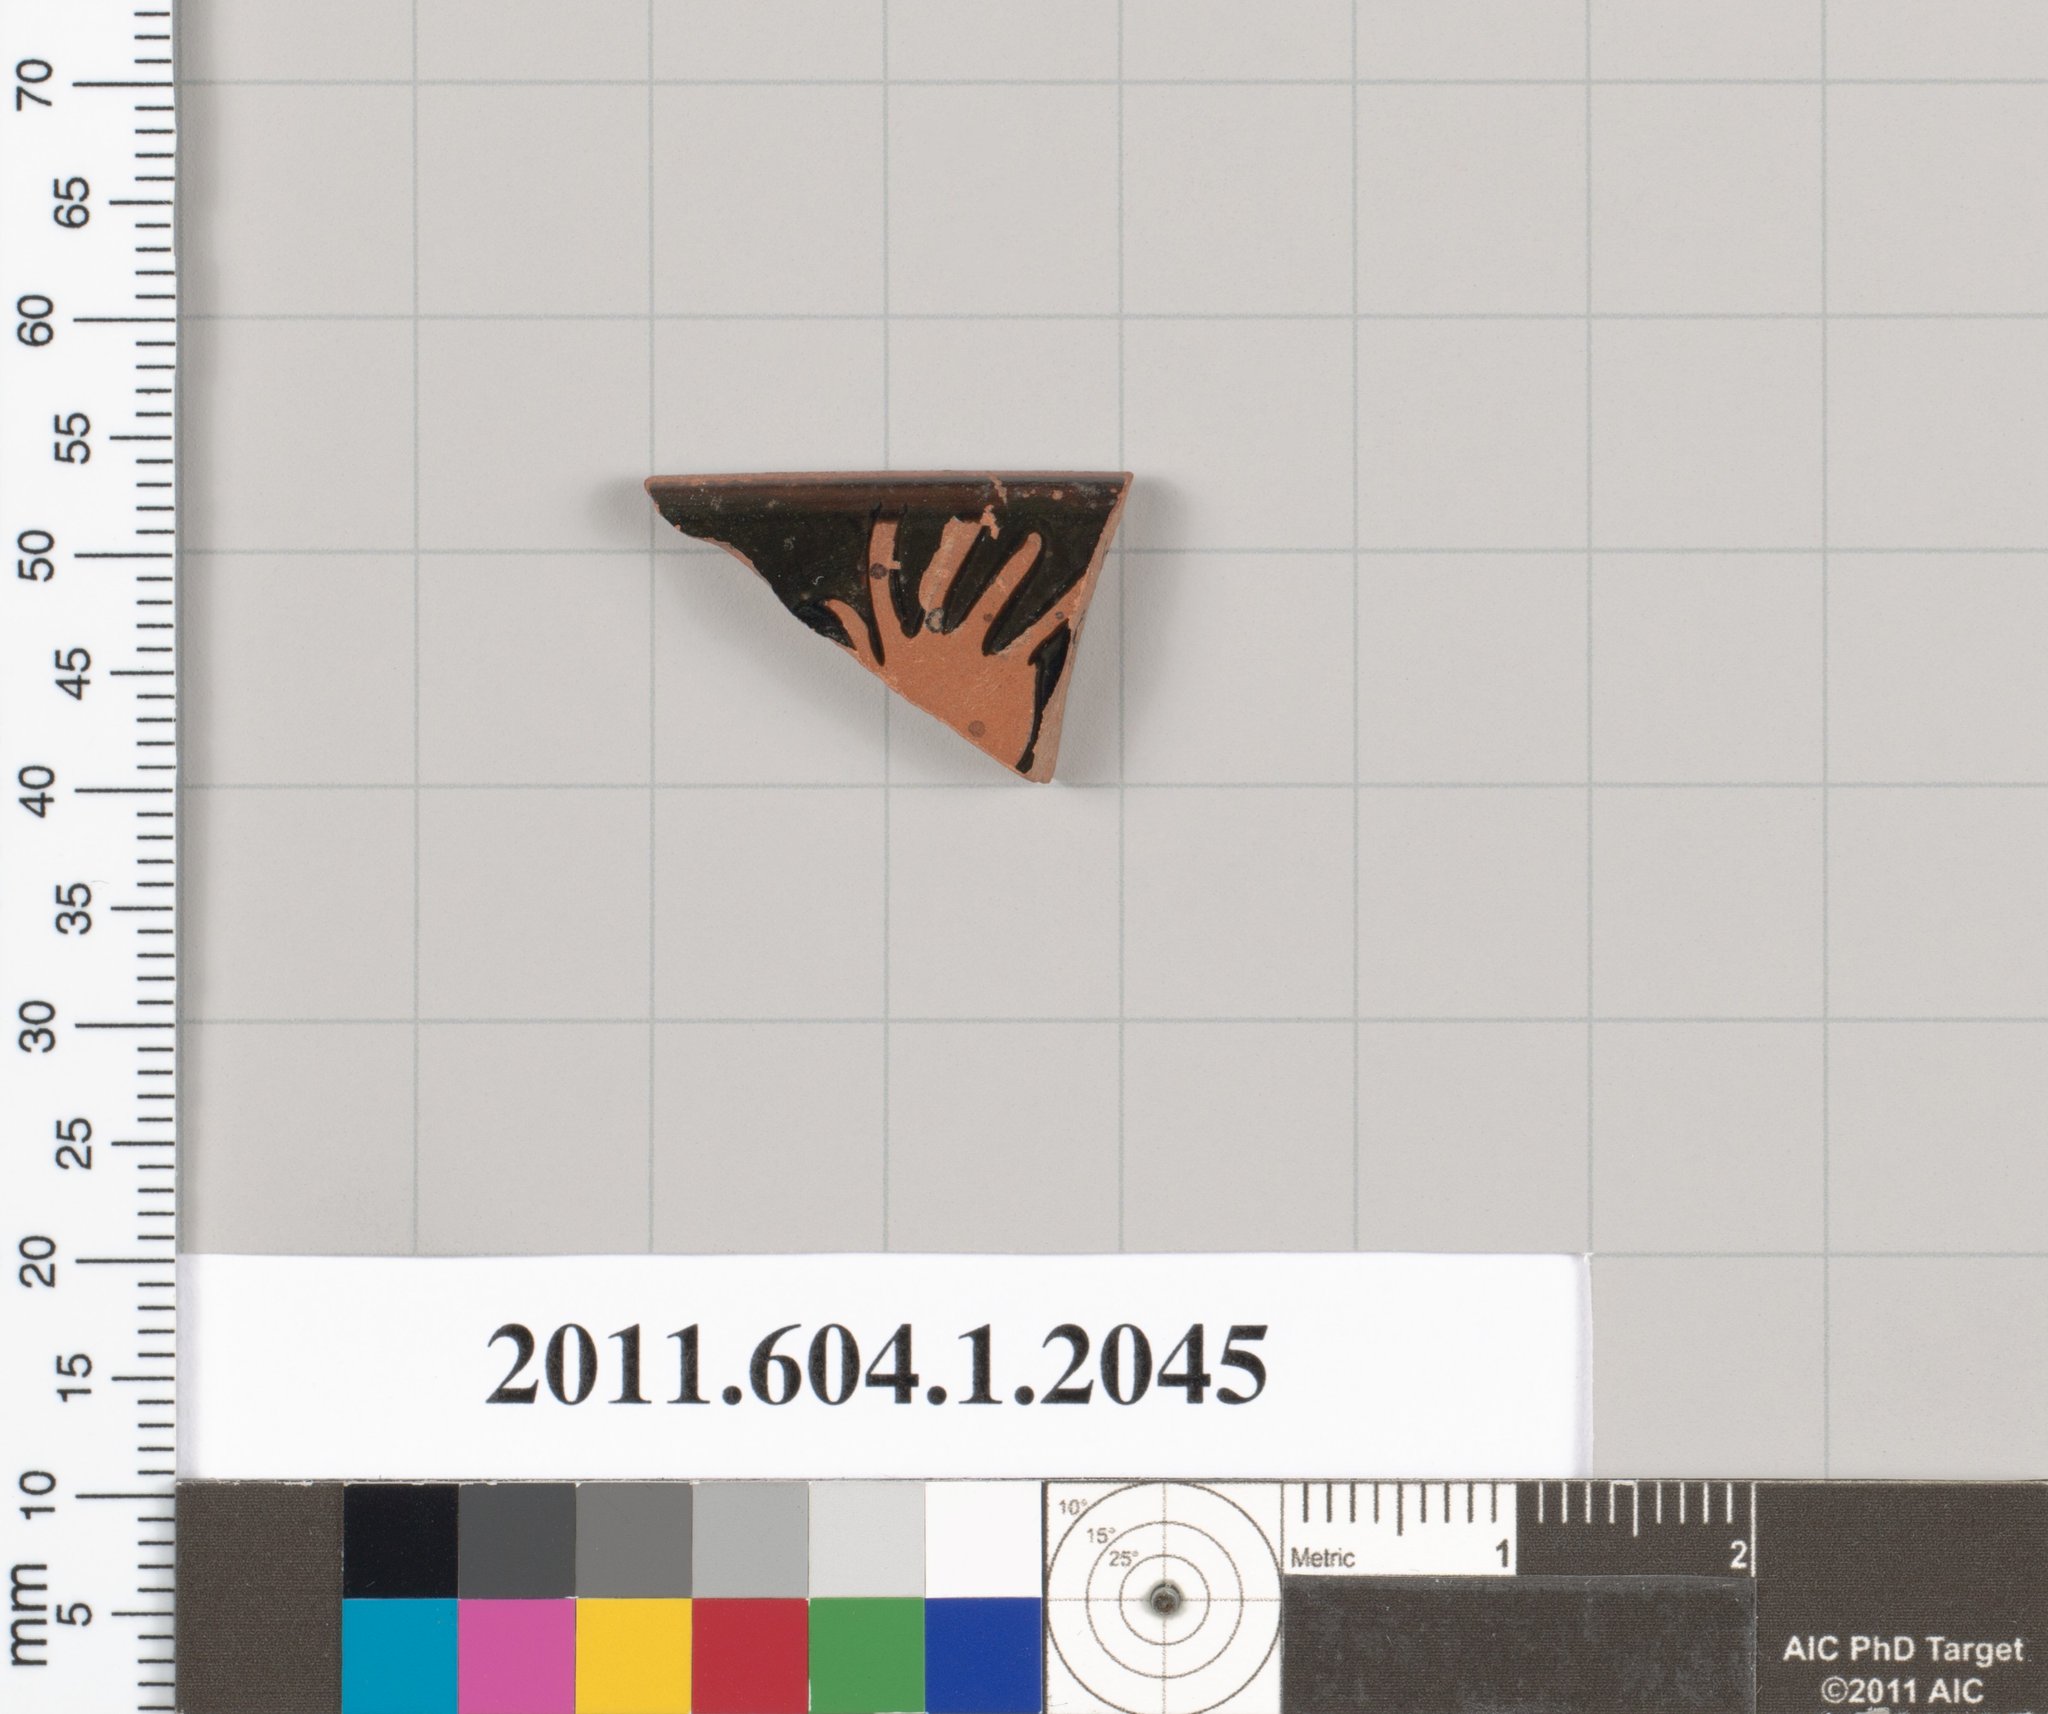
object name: kylix fragment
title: Terracotta rim fragment of a kylix (drinking cup)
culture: greek, attic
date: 500-480 BCE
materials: terracotta